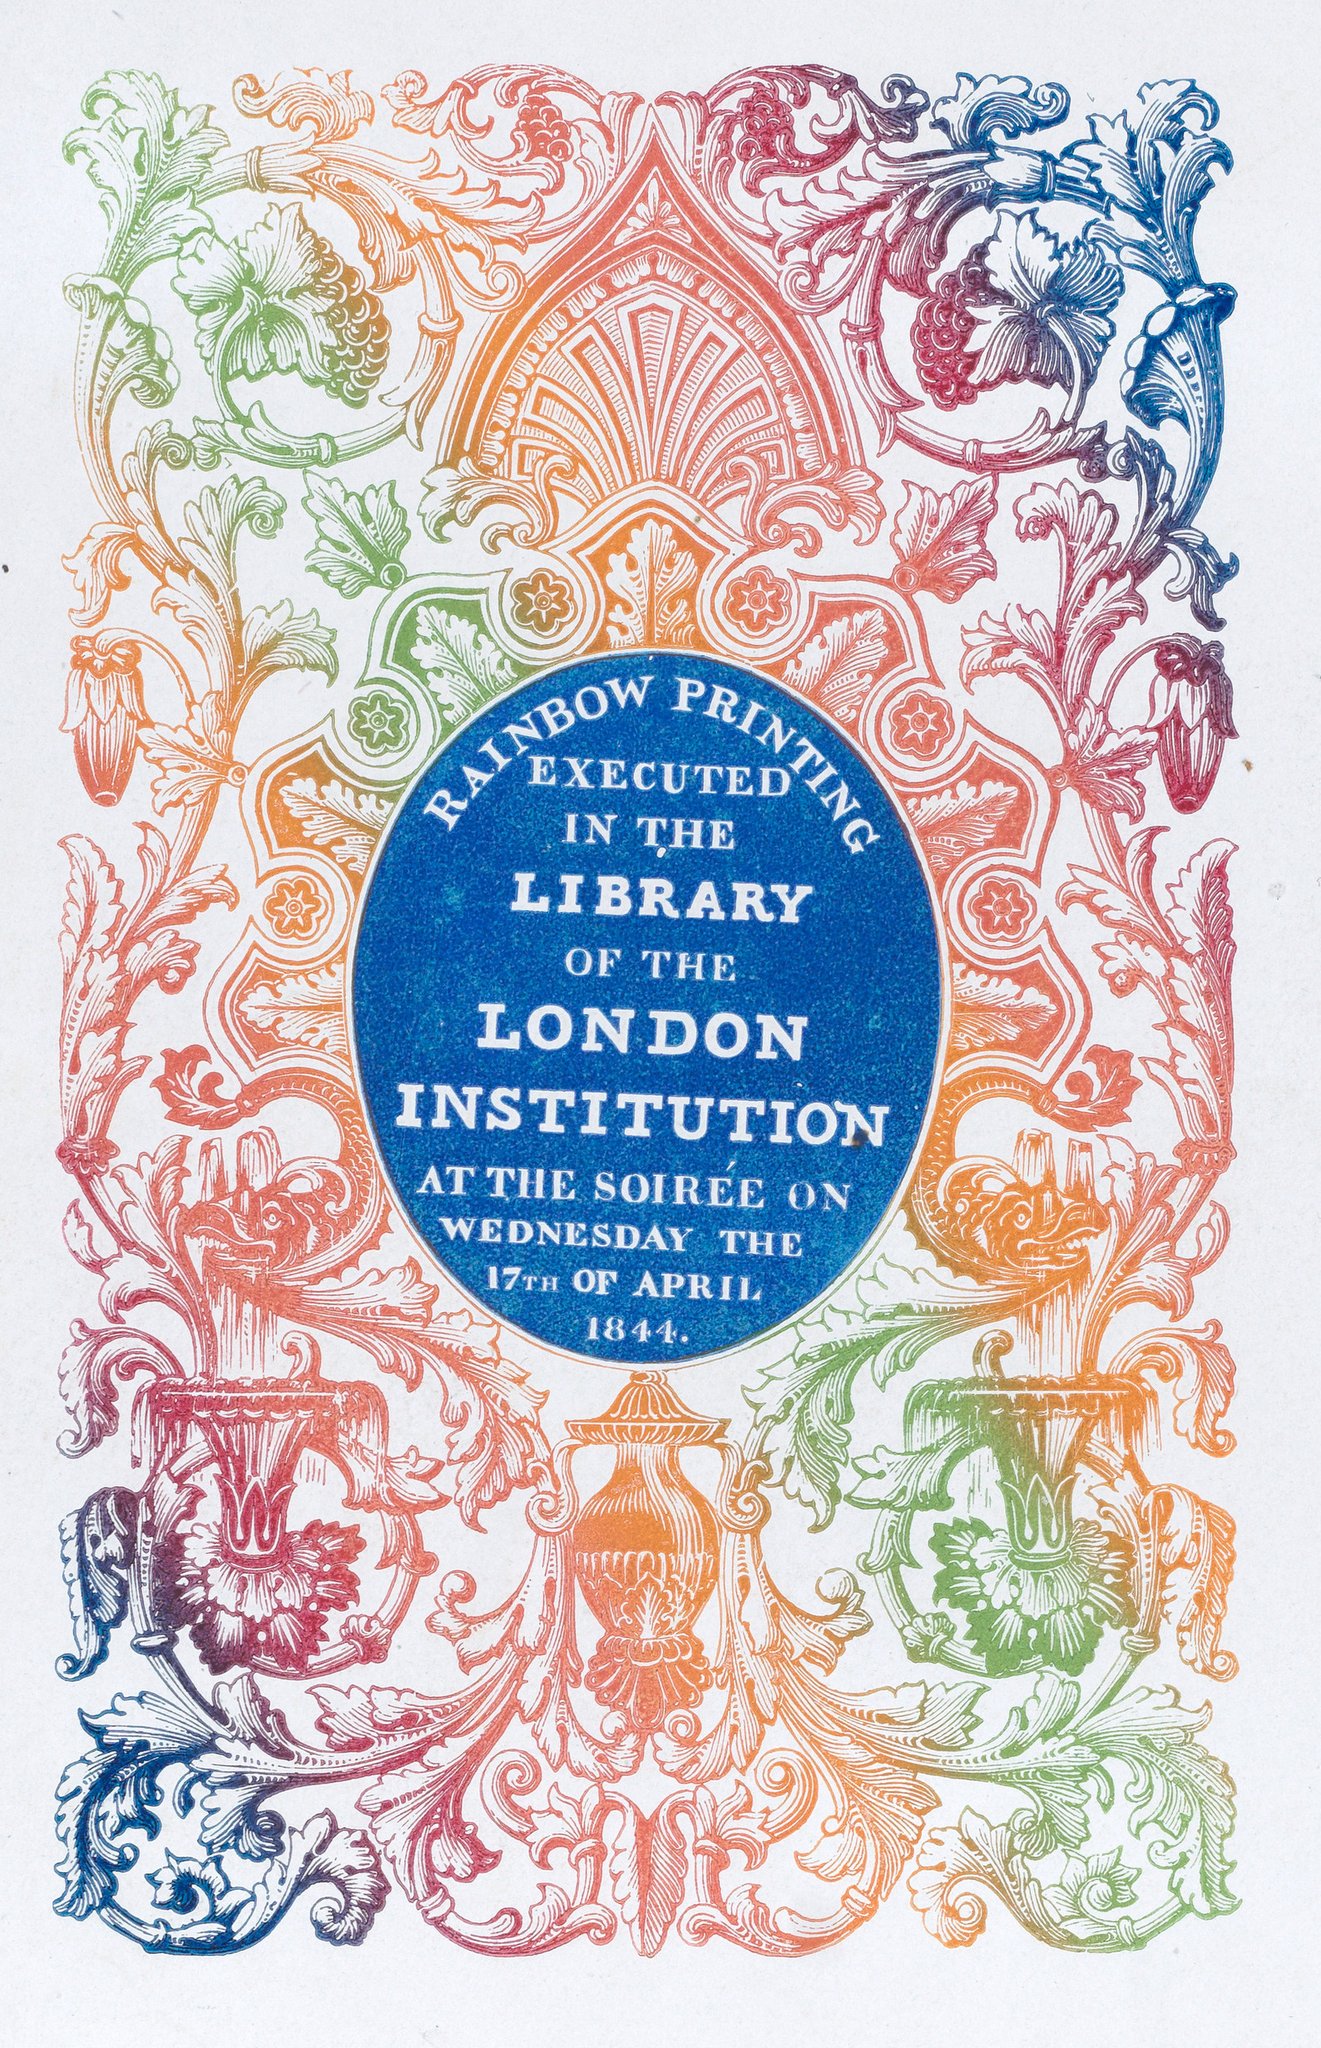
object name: print, trade card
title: Rainbow-printed Card, made during a Soirée at the Library of the London Institution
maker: anonymous, british or american, 19th century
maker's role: artist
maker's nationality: british or american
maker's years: 1800-1900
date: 1844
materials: paper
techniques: printing, engraving